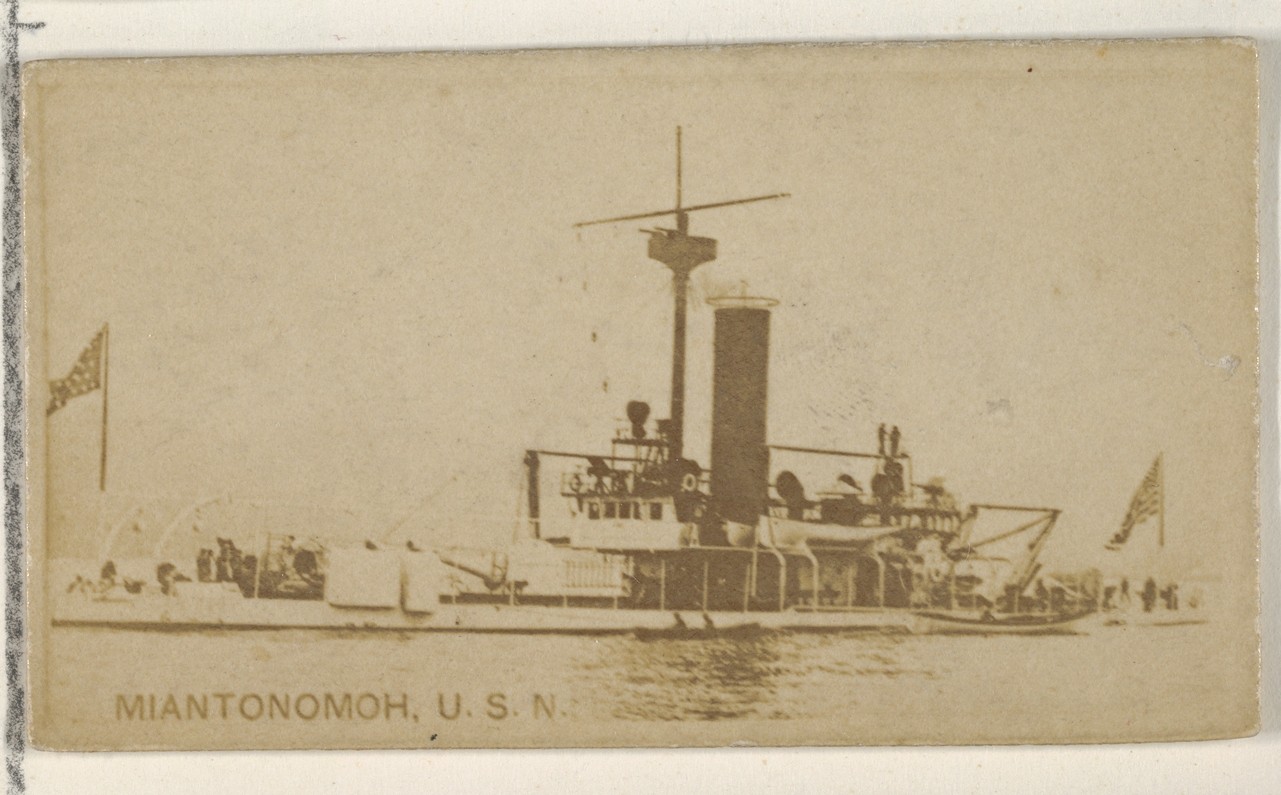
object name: photograph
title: Miantonomoh, U.S.N., from the Famous Ships series (N50) for Virginia Brights Cigarettes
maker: allen & ginter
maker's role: publisher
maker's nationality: american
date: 1895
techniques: albumen silver print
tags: ships